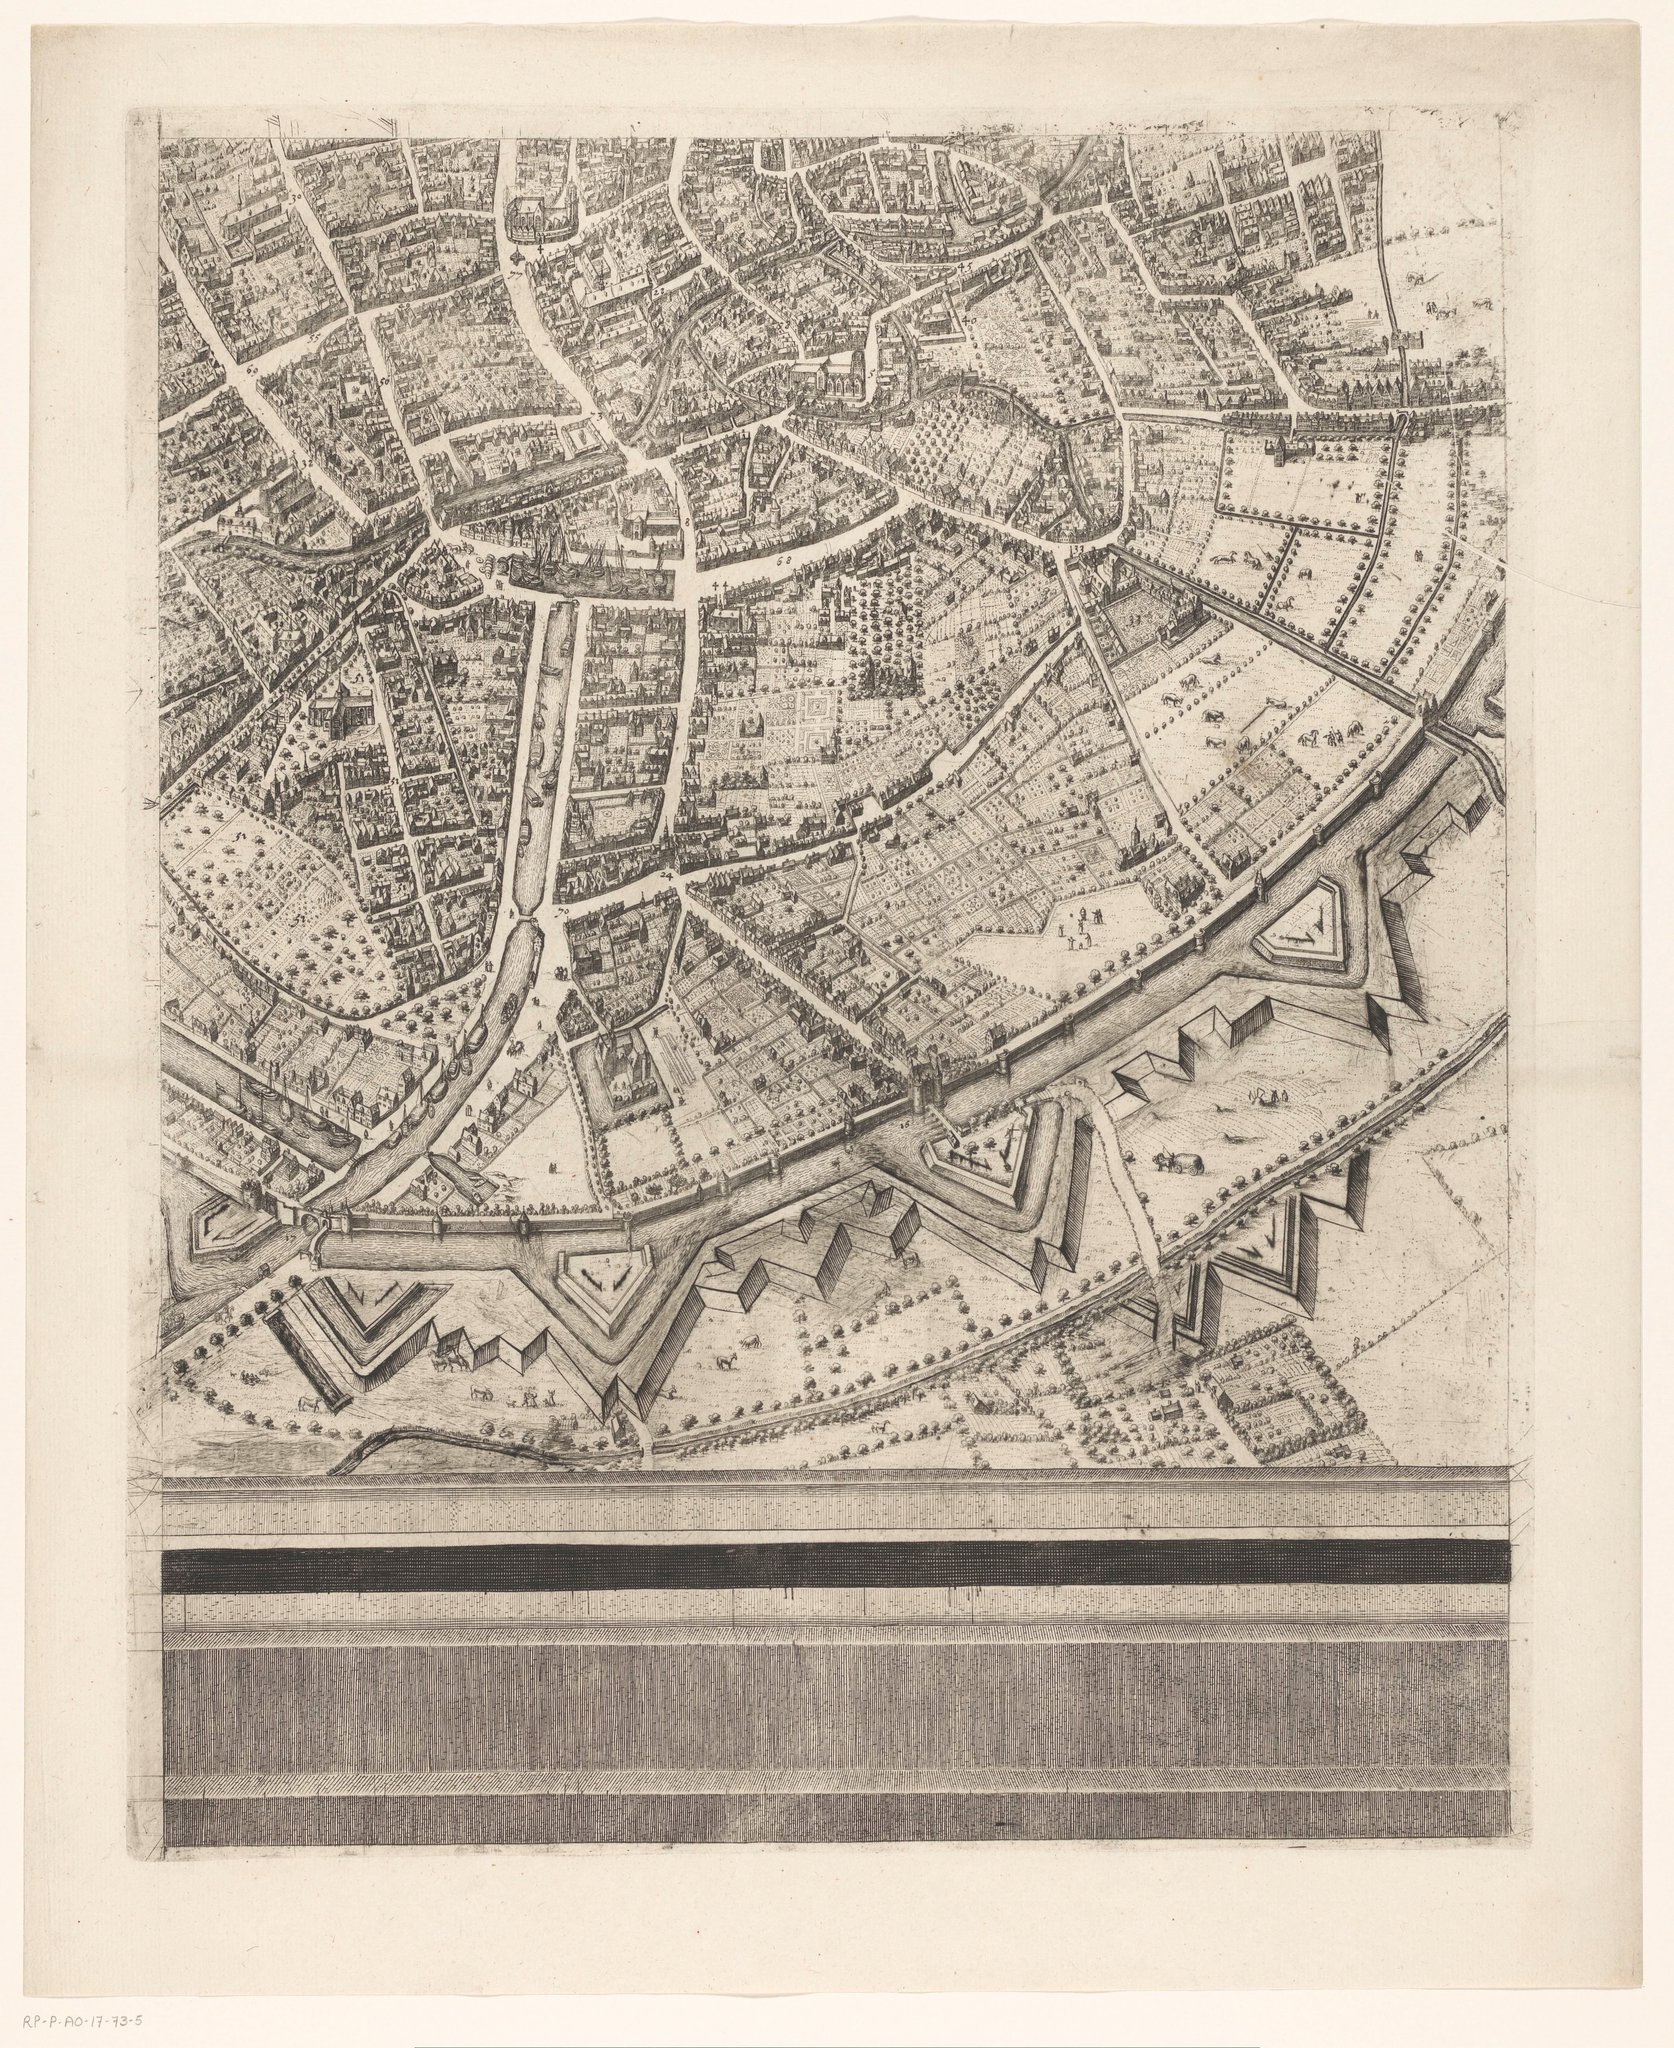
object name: area plan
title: Plattegrond van Brussel (deel midden onder)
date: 1640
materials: paper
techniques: engraving, etching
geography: brussels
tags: filips iv (koning van spanje), fortified city, maps of cities, brussels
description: Onderdeel van de plattegrond van de tweede uitgave (1748) van een wandkaart van Brussel, getiteld 'Bruxella nobilissima Brabantiae civitas restauratum ano 1748'. Deze wandkaart bestond uit deze plattegrond (gedrukt van zes platen, zie: RP-P-AO-17-73) met daaronder of daarboven een stadsgezicht (gedrukt van drie platen, zie: RP-P-AO-17-74), met langs de zijkanten een beschrijving van de stad en gezichten op gebouwen. De eerste uitgave verscheen in 1640 onder de titel 'Bruxella nobilissima Brabantiae civitas ano 1640'.